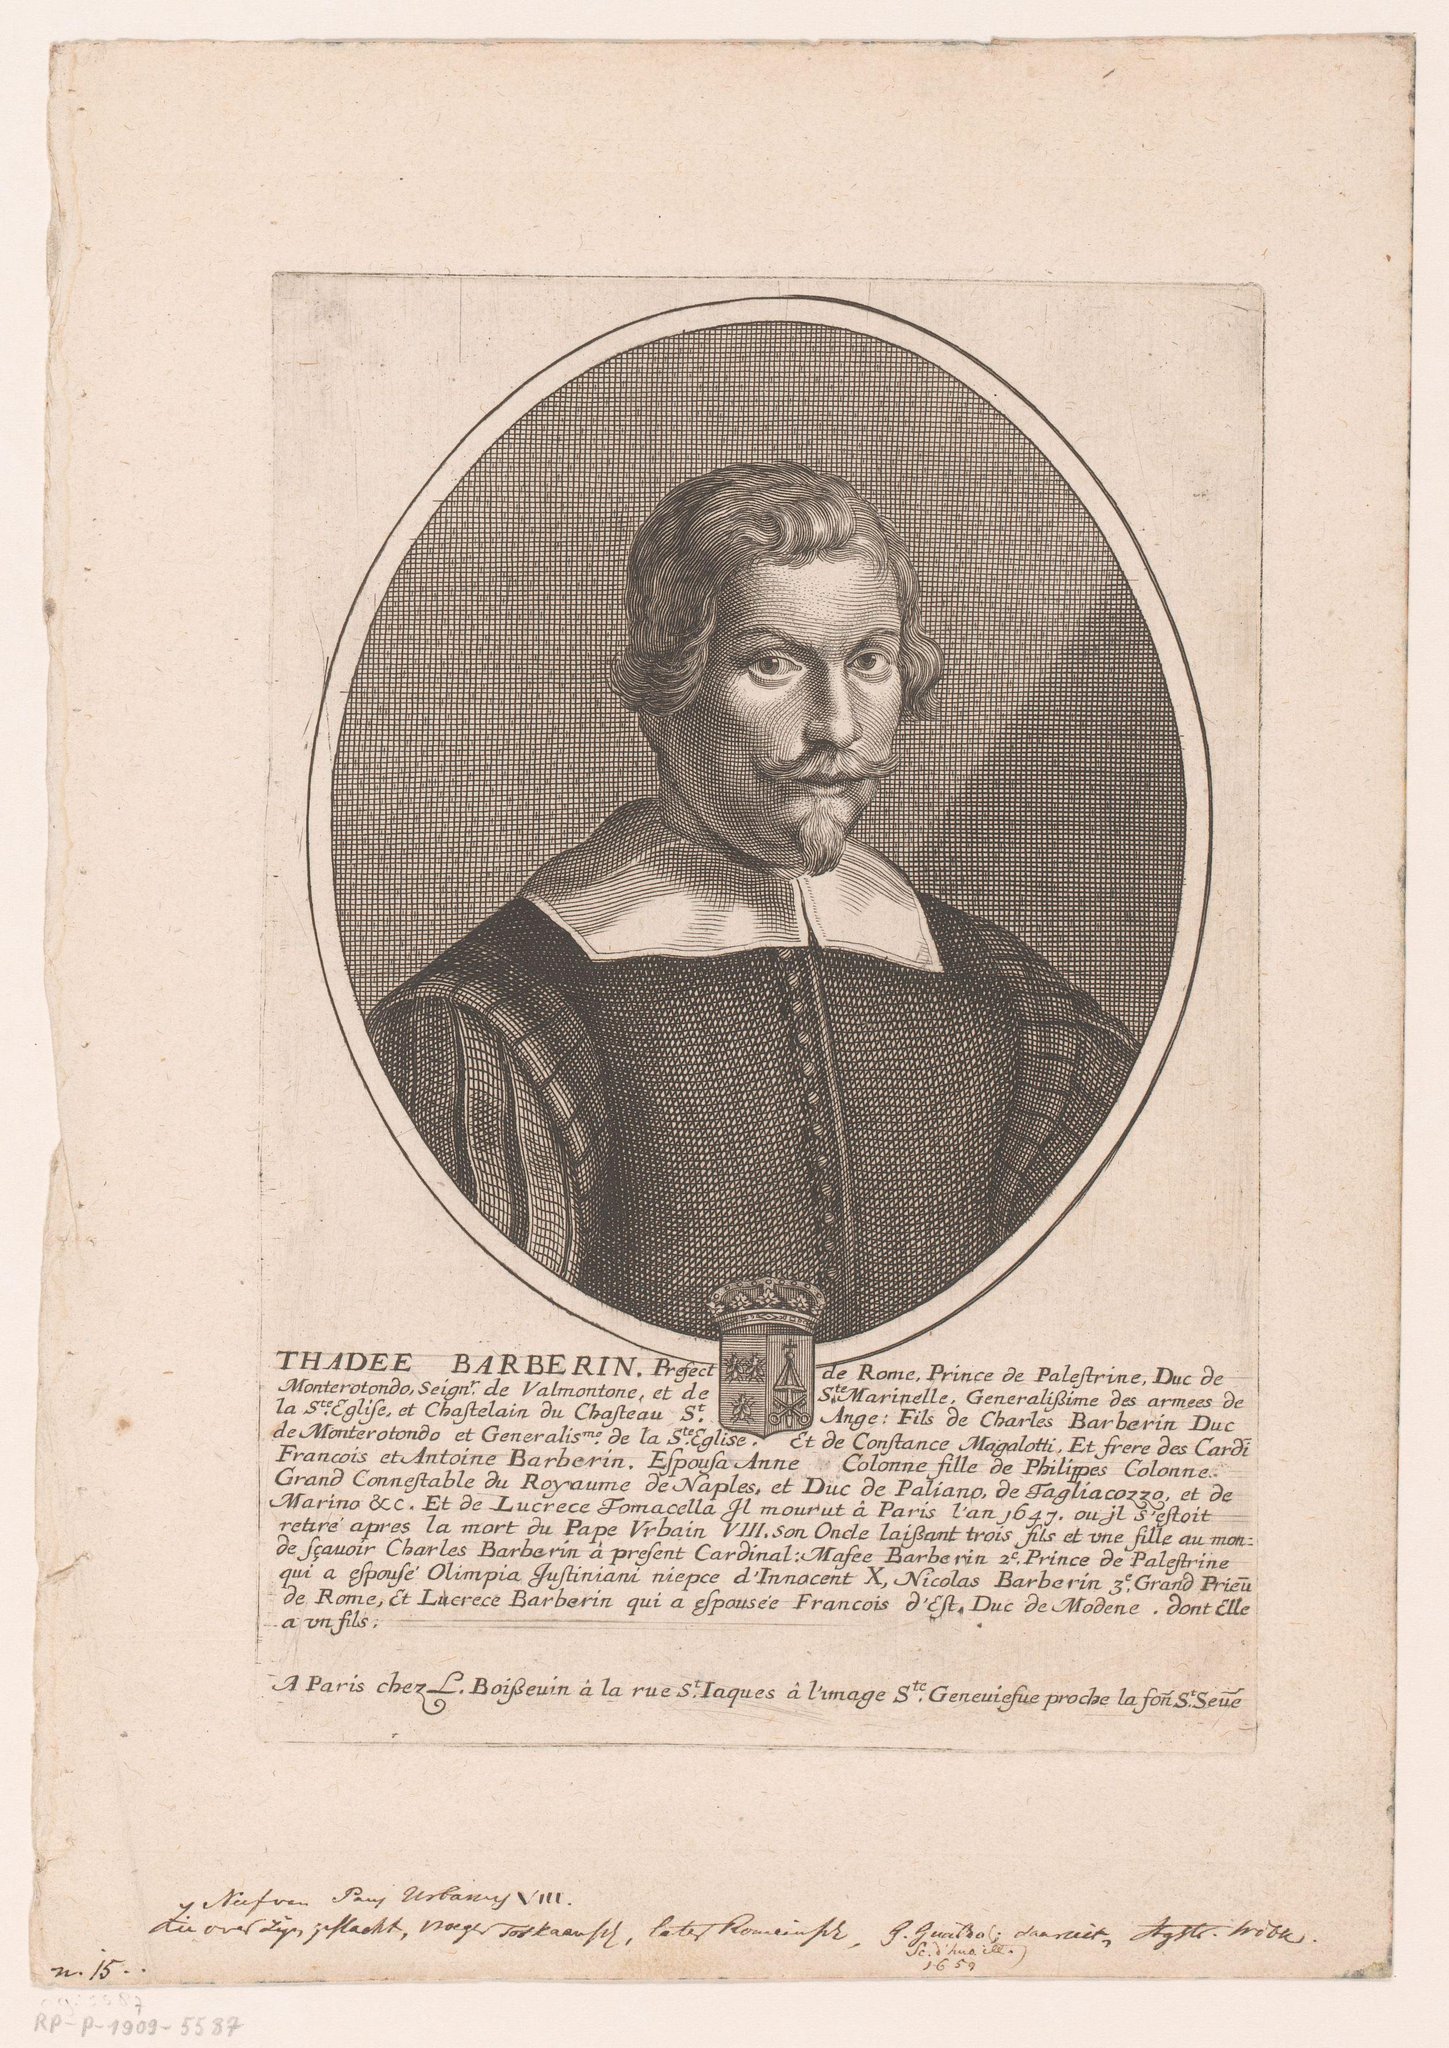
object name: print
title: Thadee Barberin.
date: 1633-1676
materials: paper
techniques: engraving, etching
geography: paris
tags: rome, paris, taddeo barberini, ornament ~ medallion, historical persons, armorial bearing, heraldry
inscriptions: inscription: ‘N[...] paus Urbnaus VIII. Ze over zijn; Macht, vroege [...], later Romein[...], G. Guibo [...] 1659’, collector's mark: Lugt 2228